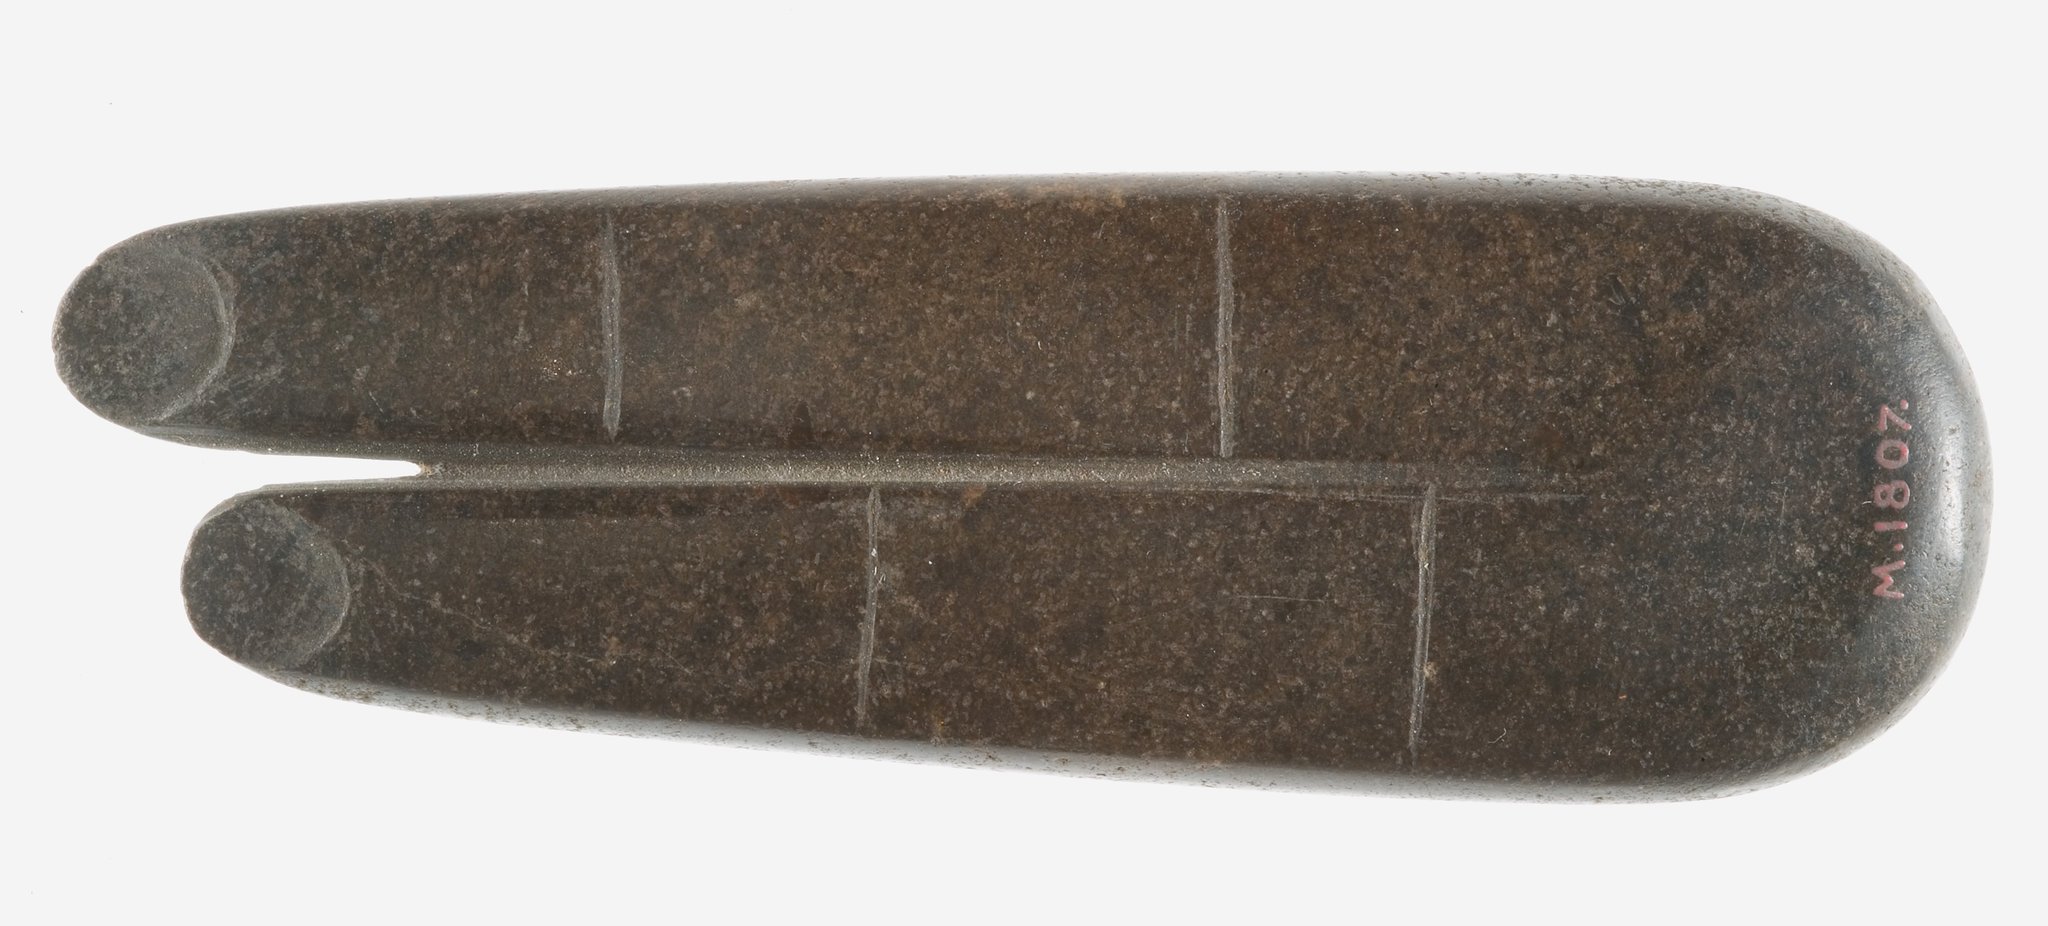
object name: amulet, two finger amulet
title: Two-finger amulet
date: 664-332 BCE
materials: stone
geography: egypt